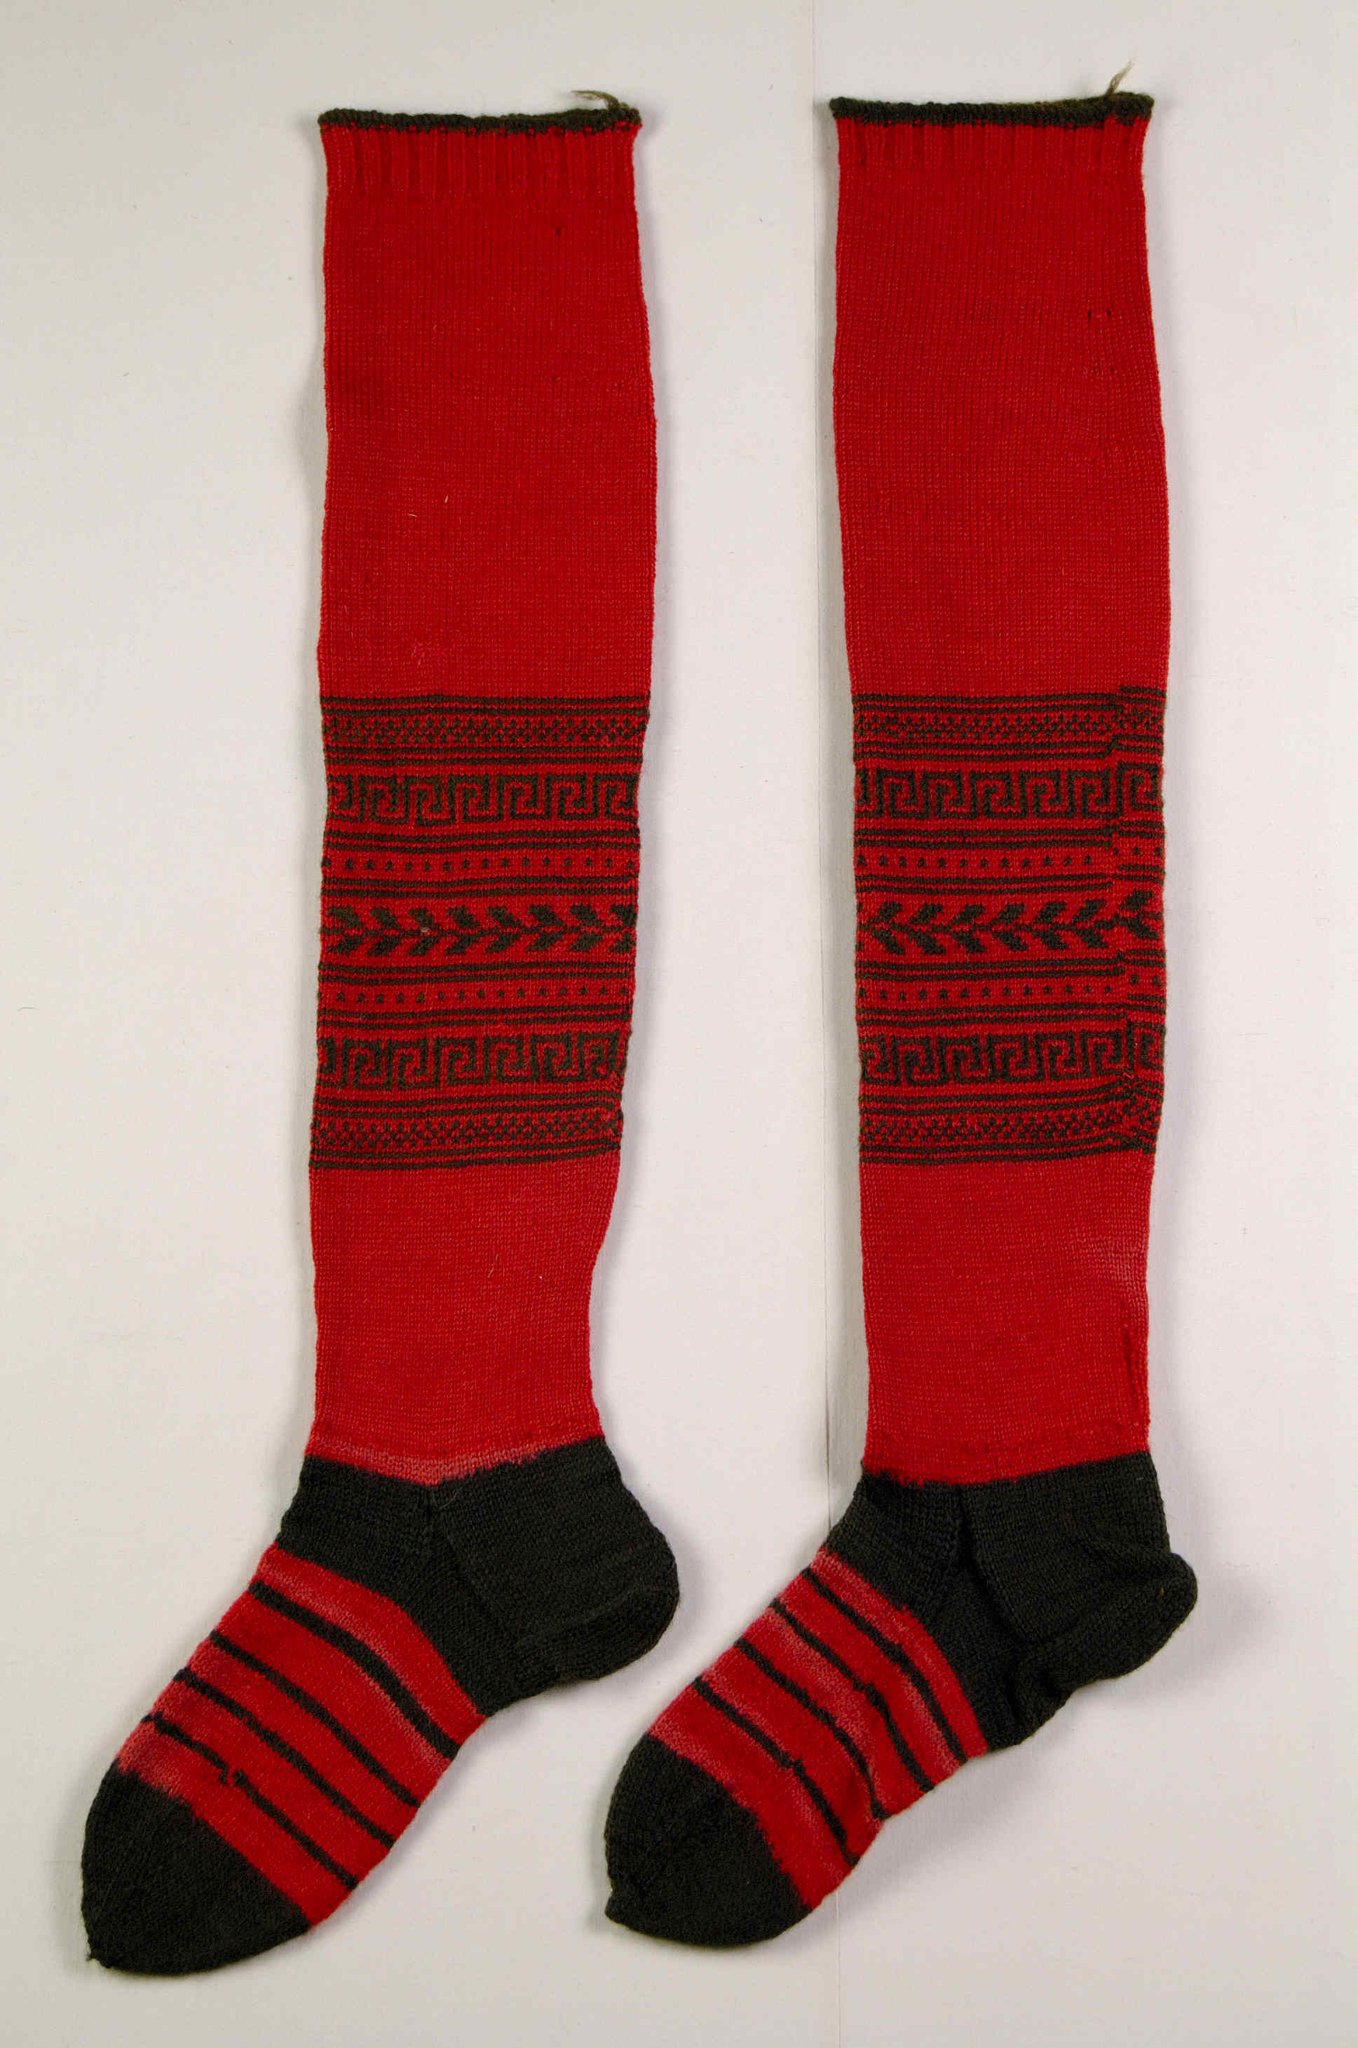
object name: stocking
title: Stockings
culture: american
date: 1878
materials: wool